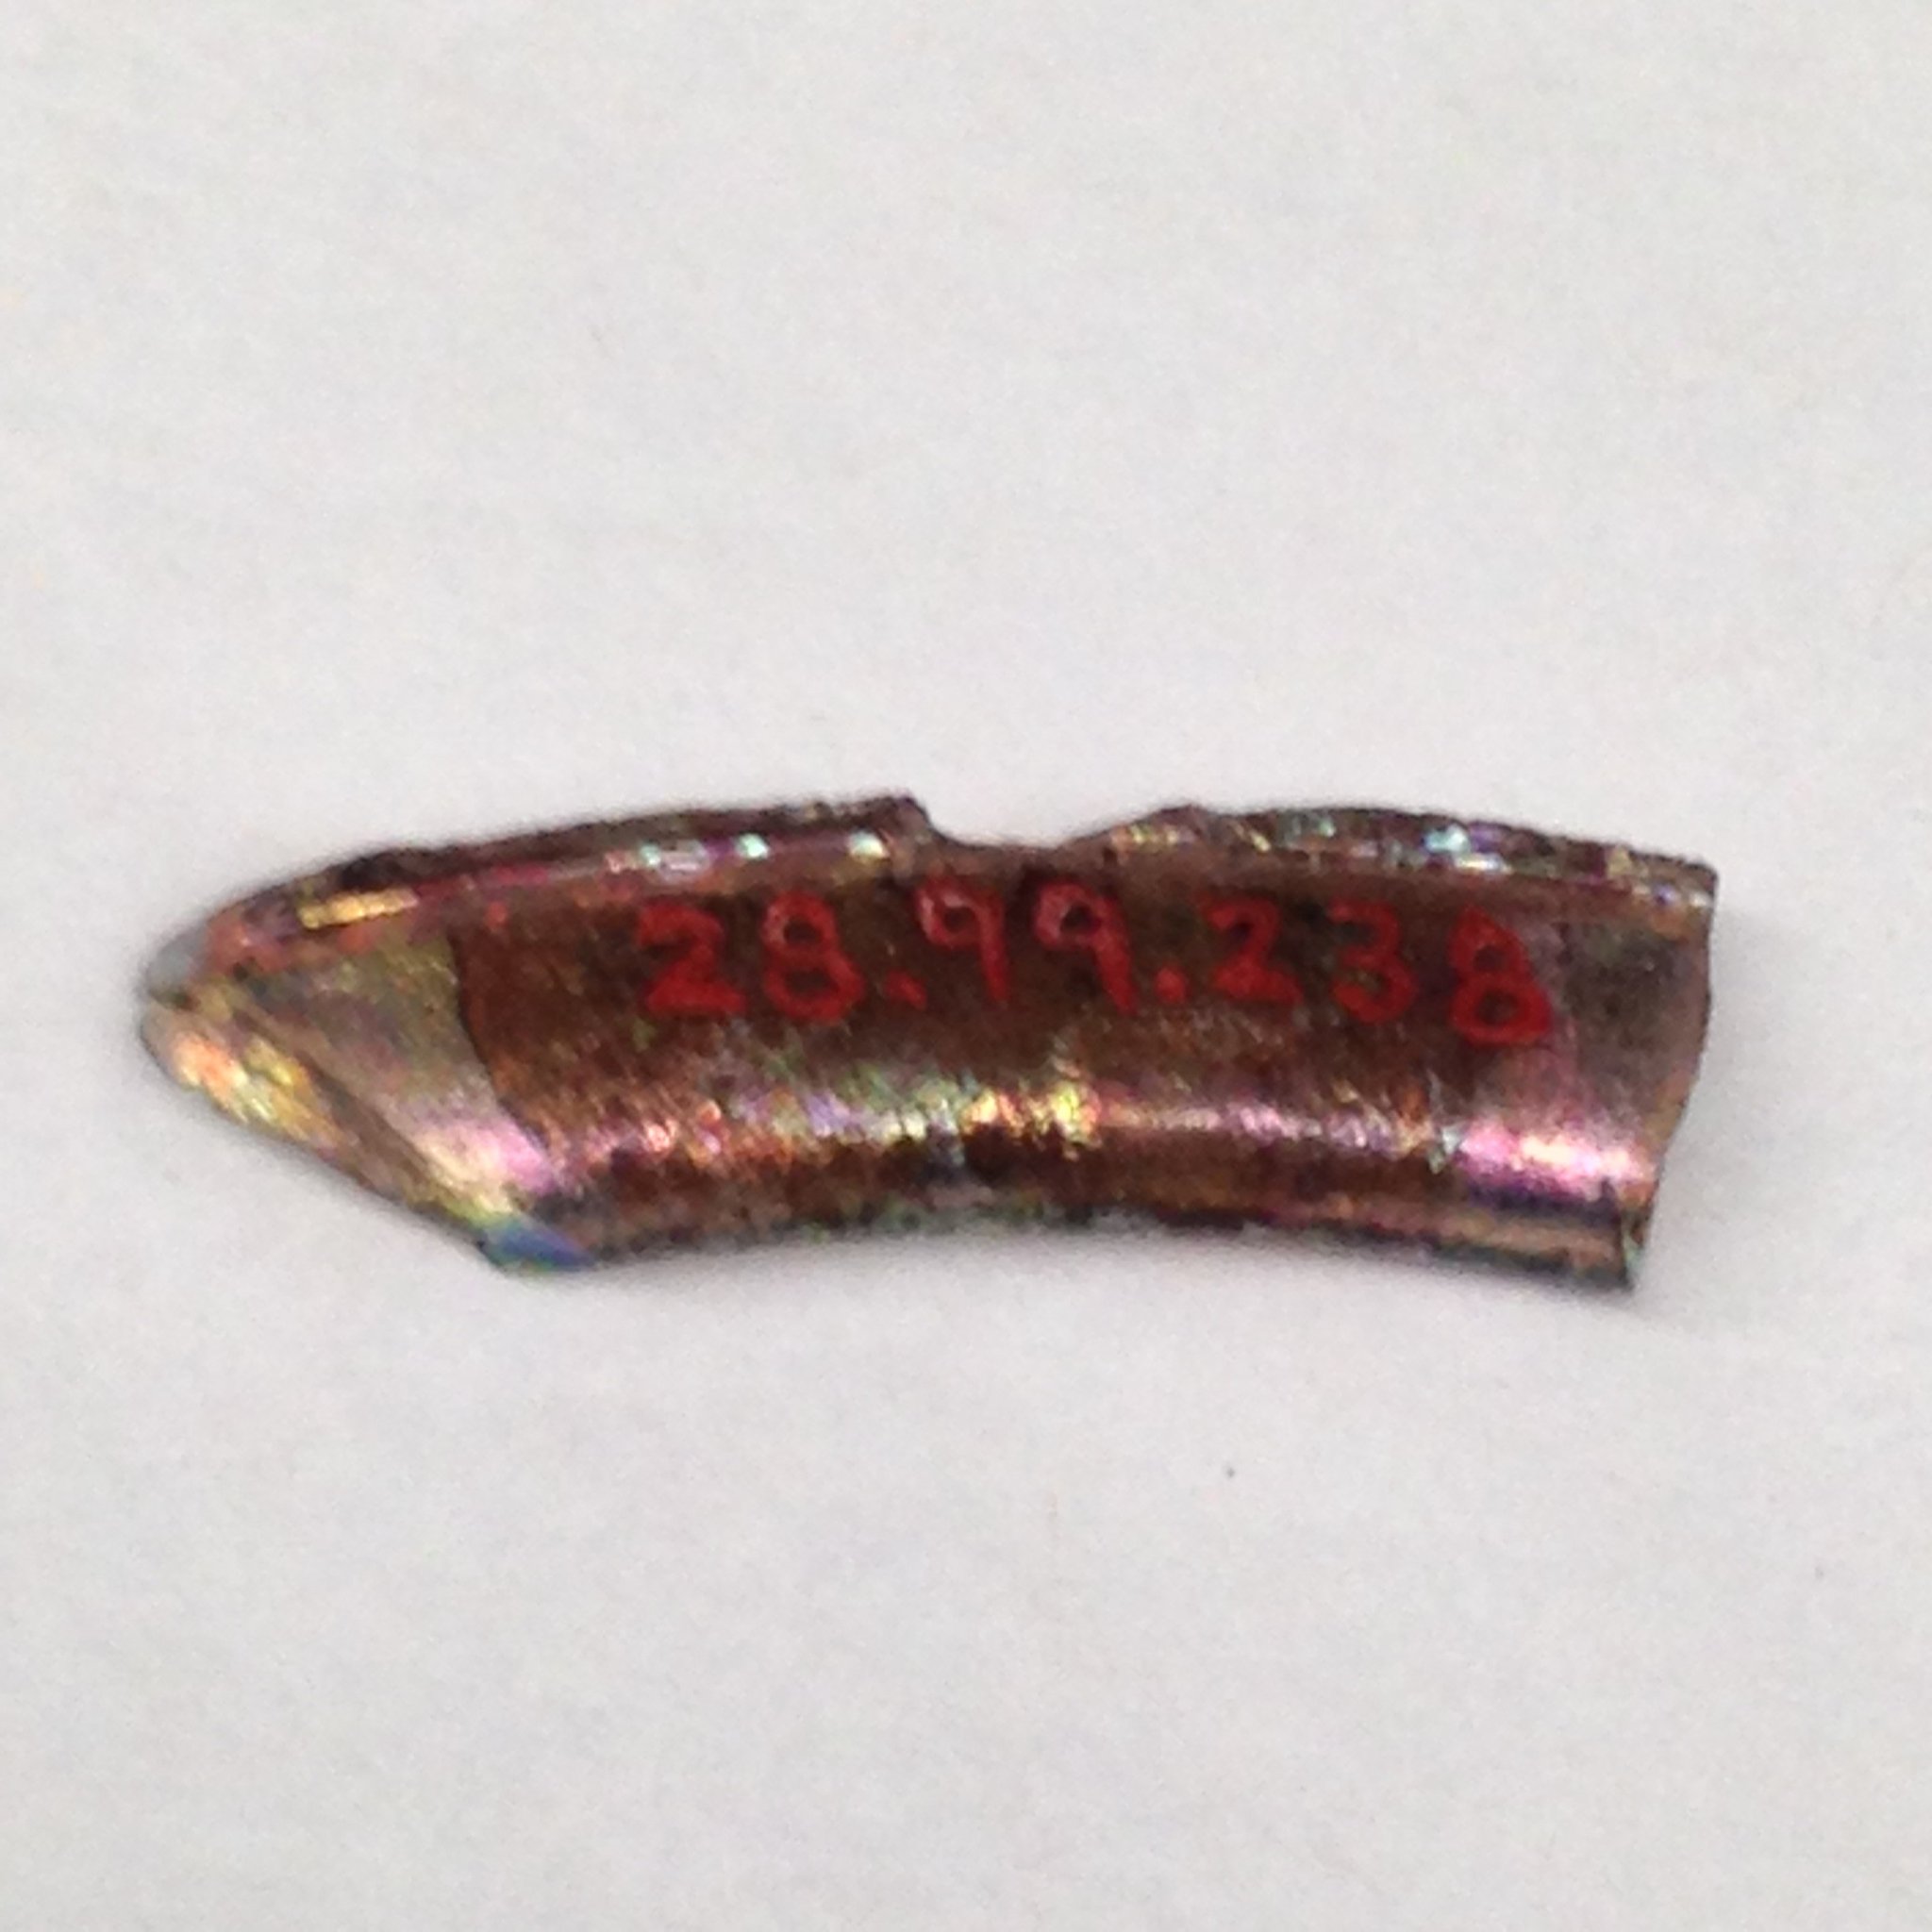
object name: fragment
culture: european or middle eastern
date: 1150-1250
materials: ceramic, glass